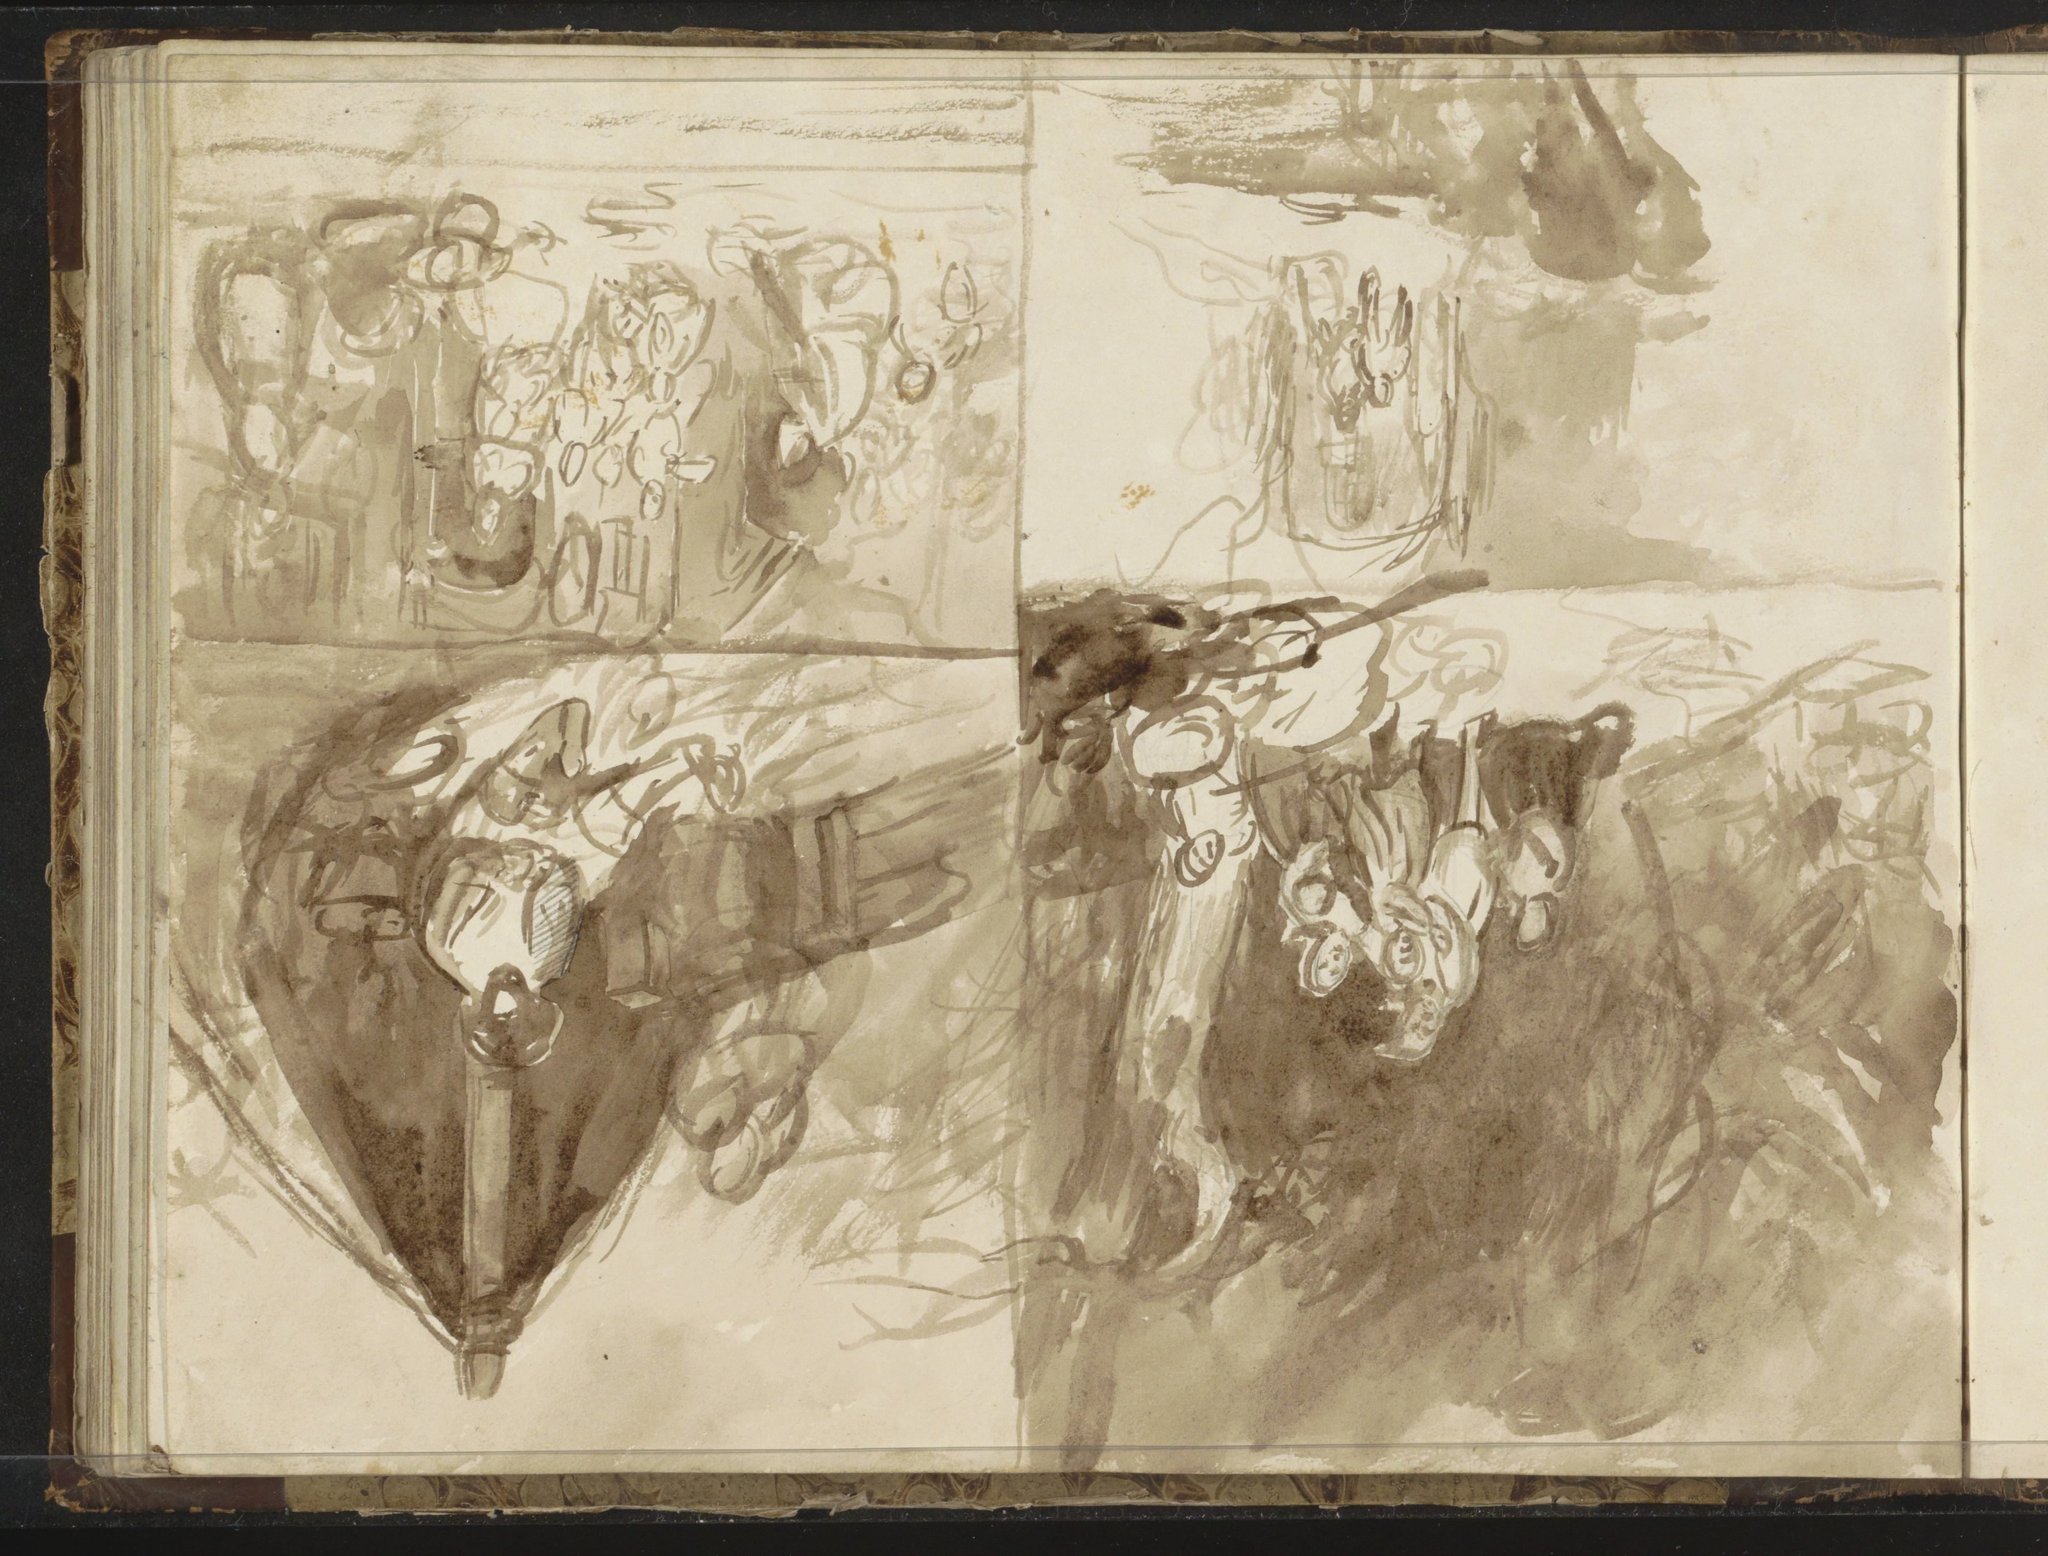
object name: sketchbook leaf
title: Landschappen en straatscènes met figuren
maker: willem hendrik schmidt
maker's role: draughtsman, painter, print maker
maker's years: 1809-1849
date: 1819-1849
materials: paper, pencil, watercolor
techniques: brush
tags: landscapes (+ landscape with figures, staffage), street (+ city(-scape) with figures, staffage)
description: Blad 40 verso uit een schetsboek met 52 bladen.